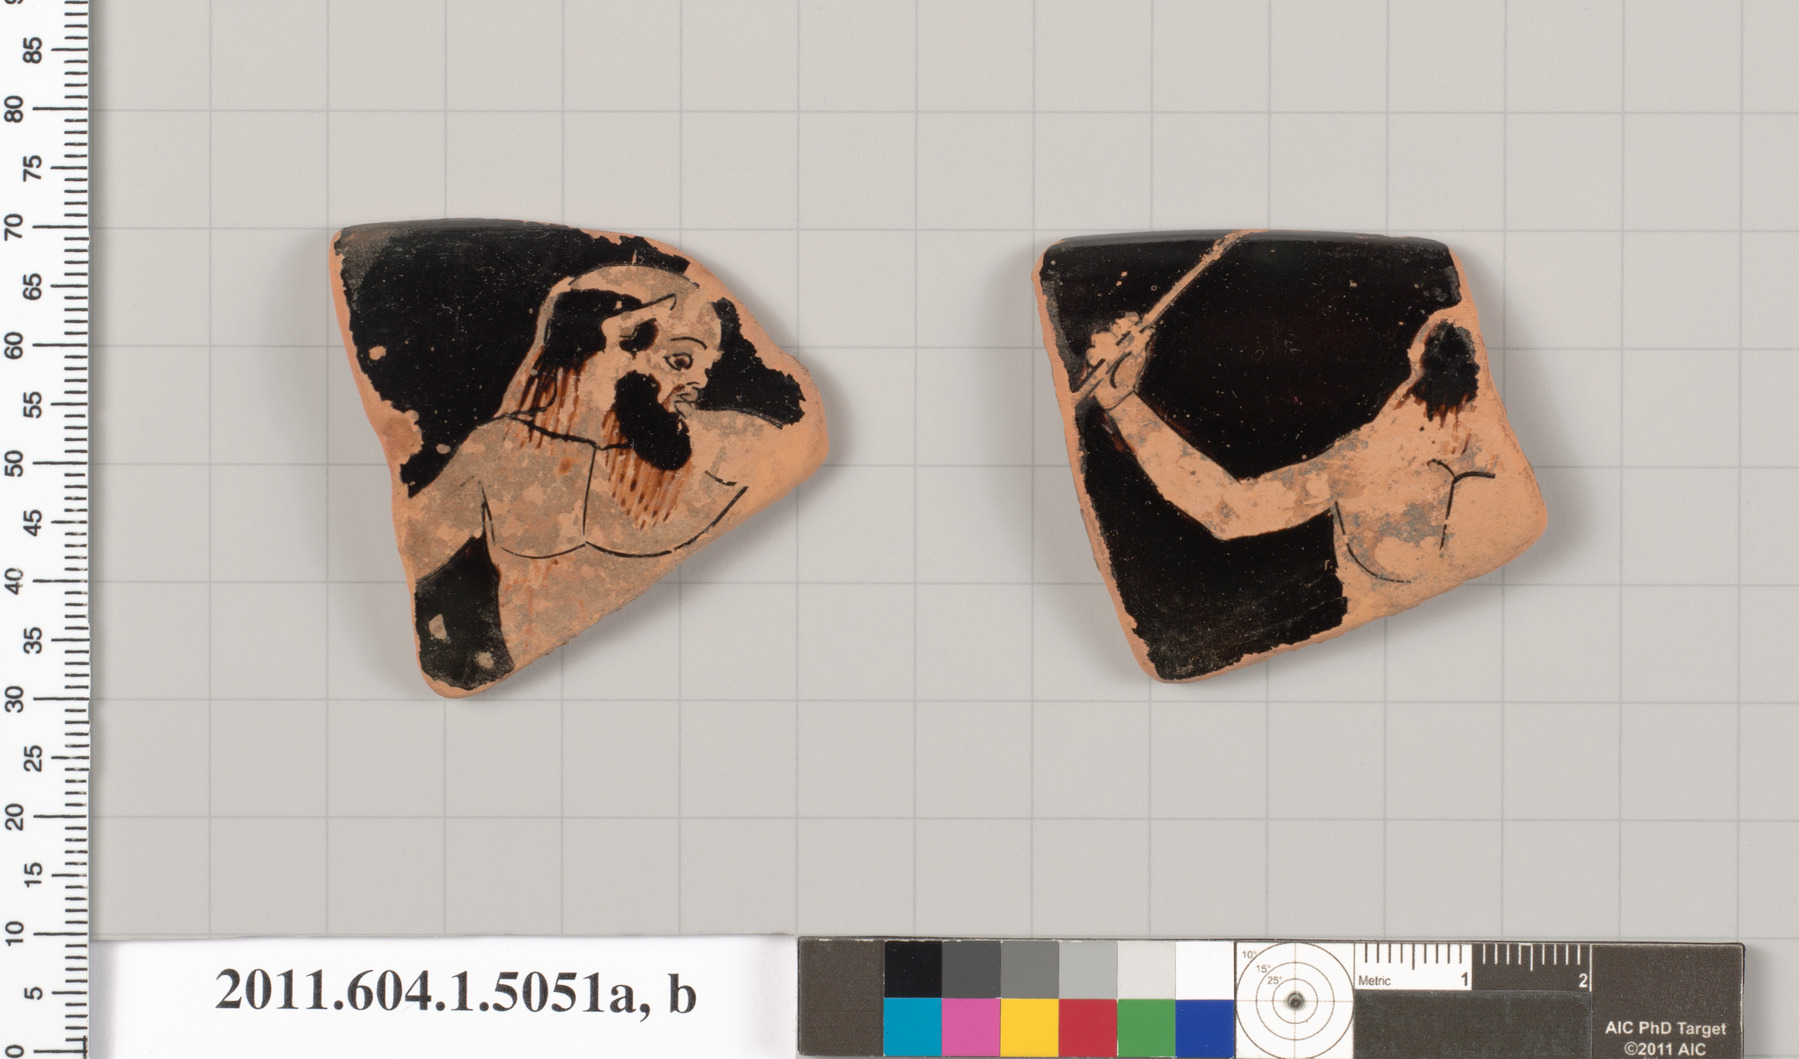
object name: kylix fragment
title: Terracotta rim fragments of a kylix (drinking cup)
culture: greek, attic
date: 475-451 BCE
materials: terracotta